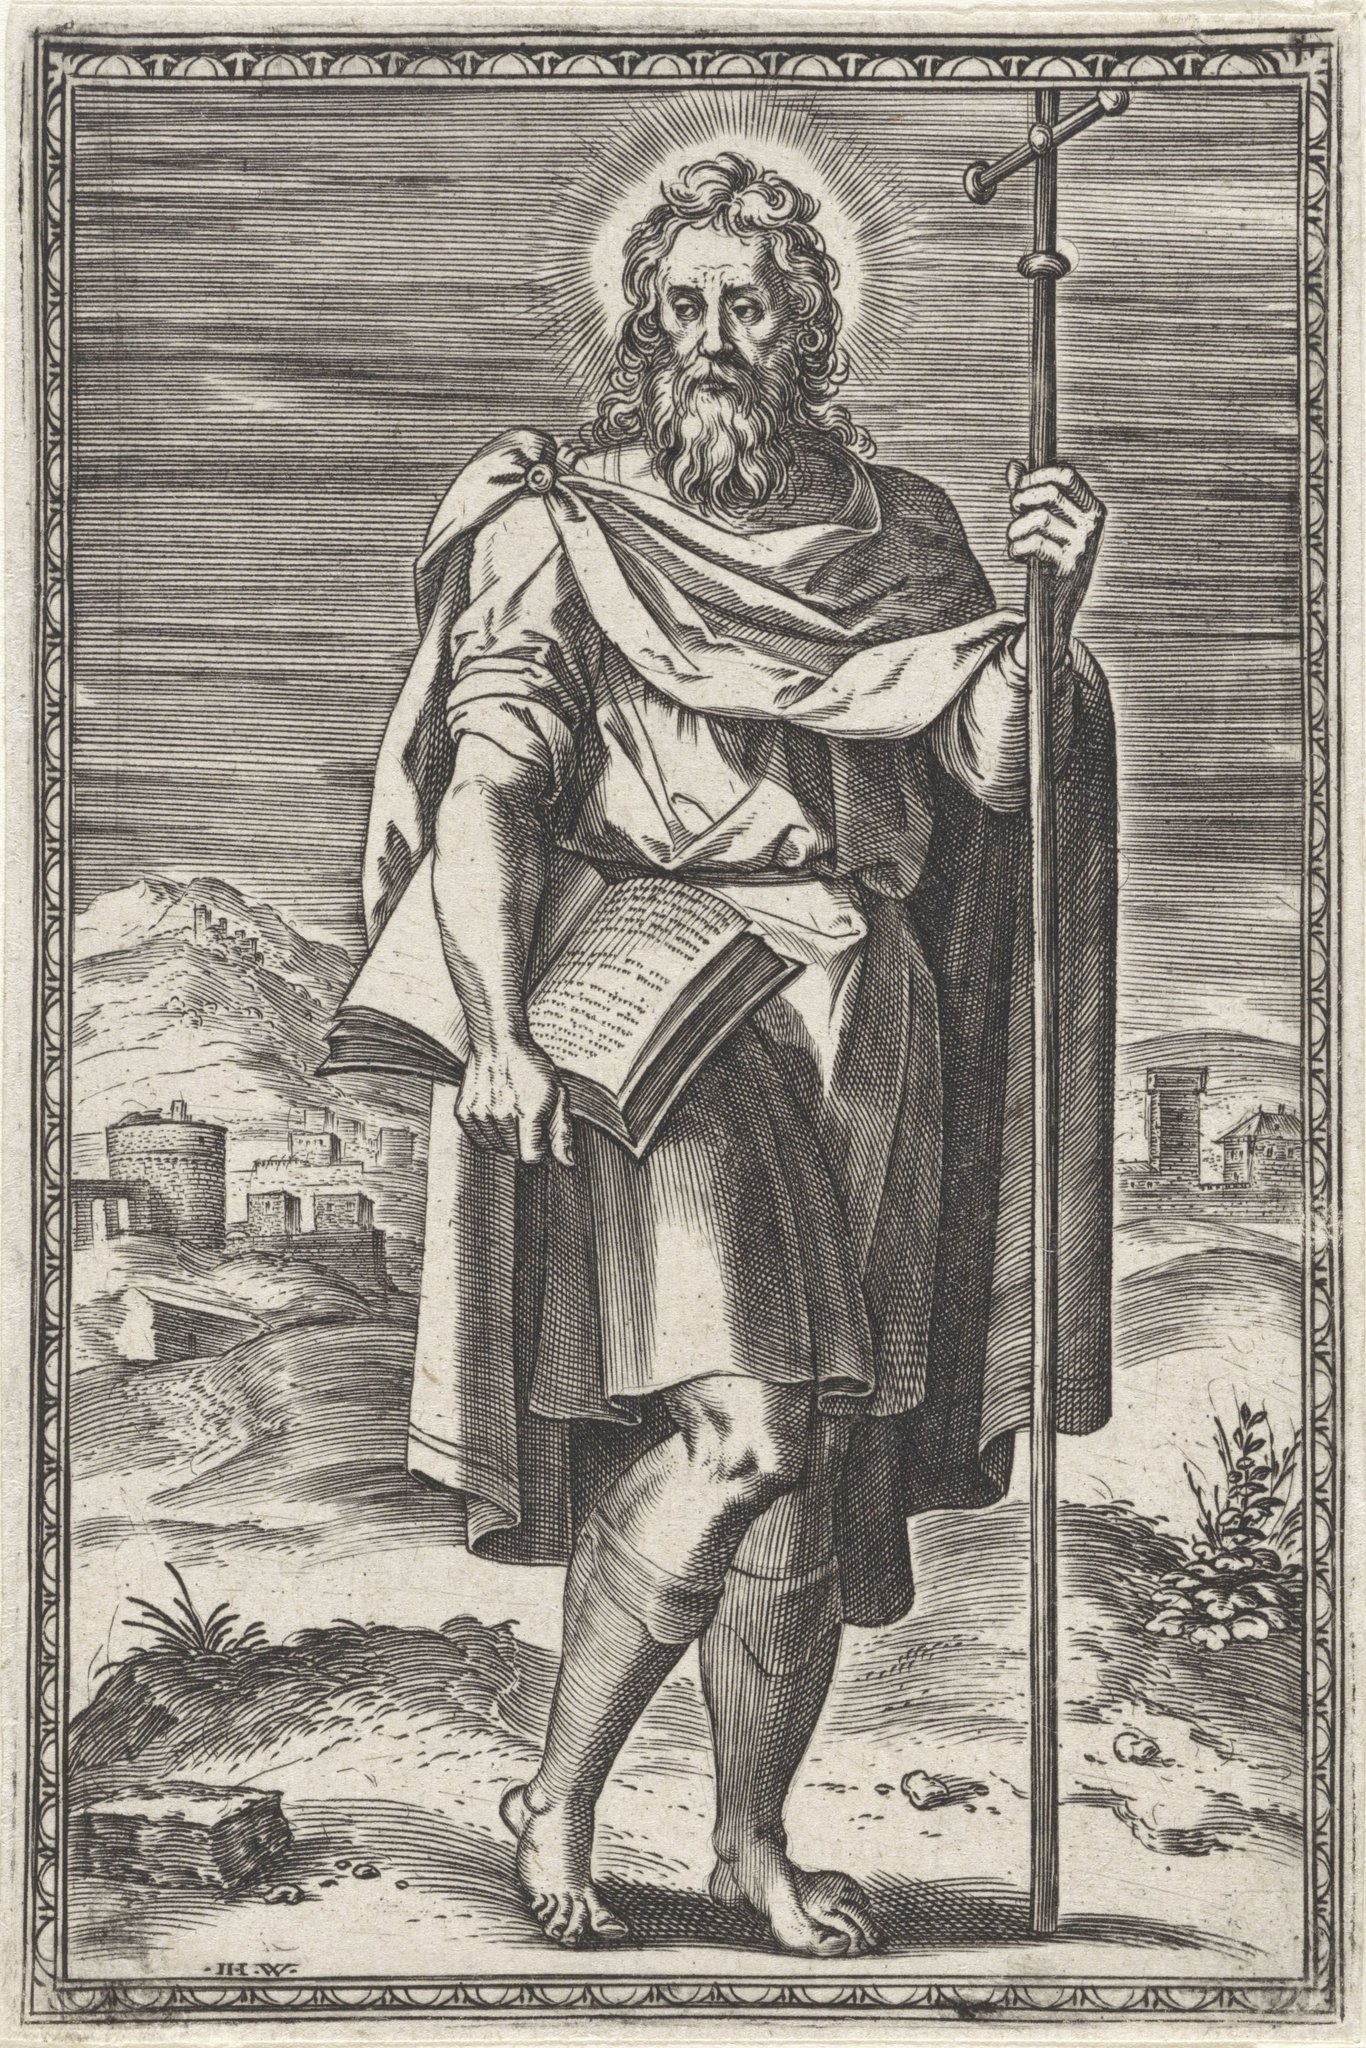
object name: print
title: Christus en de twaalf apostelen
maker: johannes wierix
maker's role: draughtsman, print maker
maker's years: 1549-1618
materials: paper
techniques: engraving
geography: antwerp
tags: the apostle philip; possible attributes: book, cross, dish with snake, lance, scroll, stone, sword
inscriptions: number: ‘38.- 84.’, collector's mark: Lugt 2228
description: Landschap met de apostel Filippus. In zijn ene hand houdt hij een kruisstaf, in zijn andere hand een opengeslagen boek.